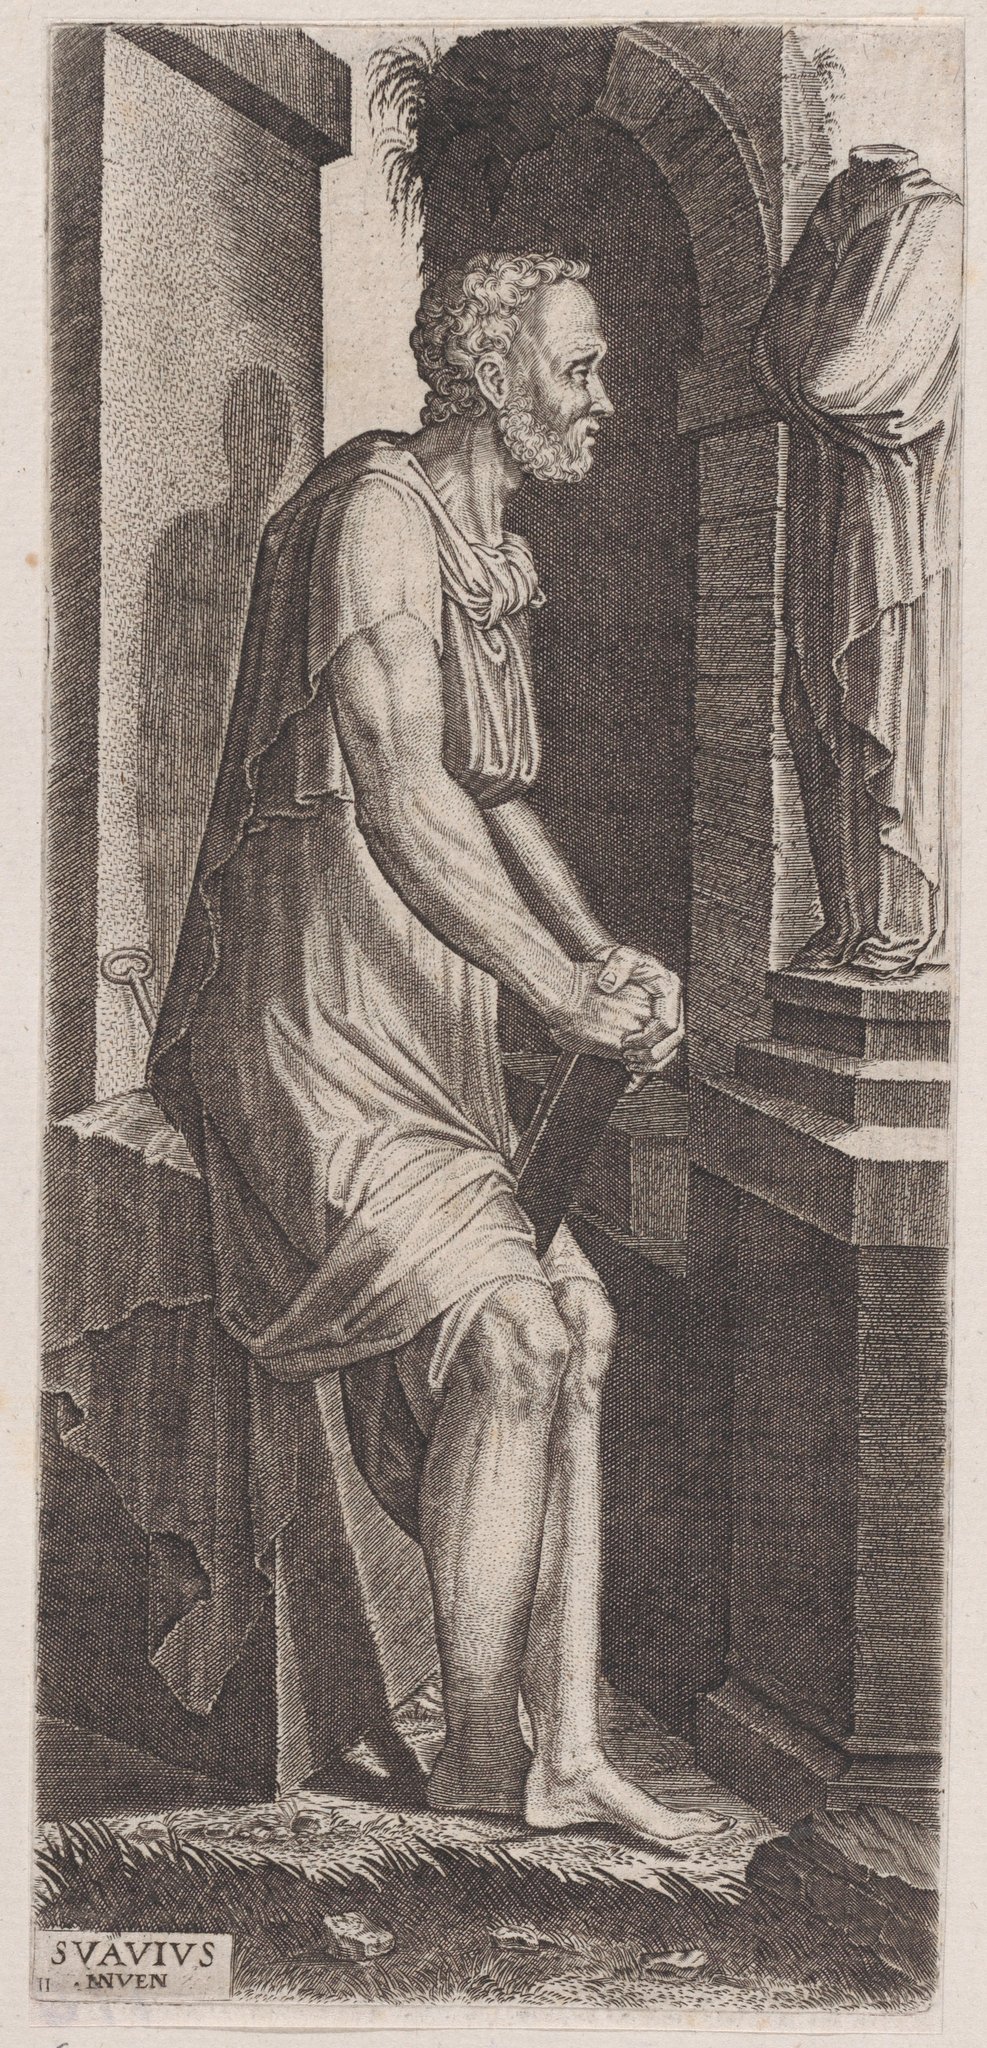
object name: print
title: St. Peter, from "Christ, the Twelve Apostles and St. Paul"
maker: lambert suavius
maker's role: artist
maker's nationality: netherlandish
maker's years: 1510-1576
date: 1525-1576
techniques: engraving